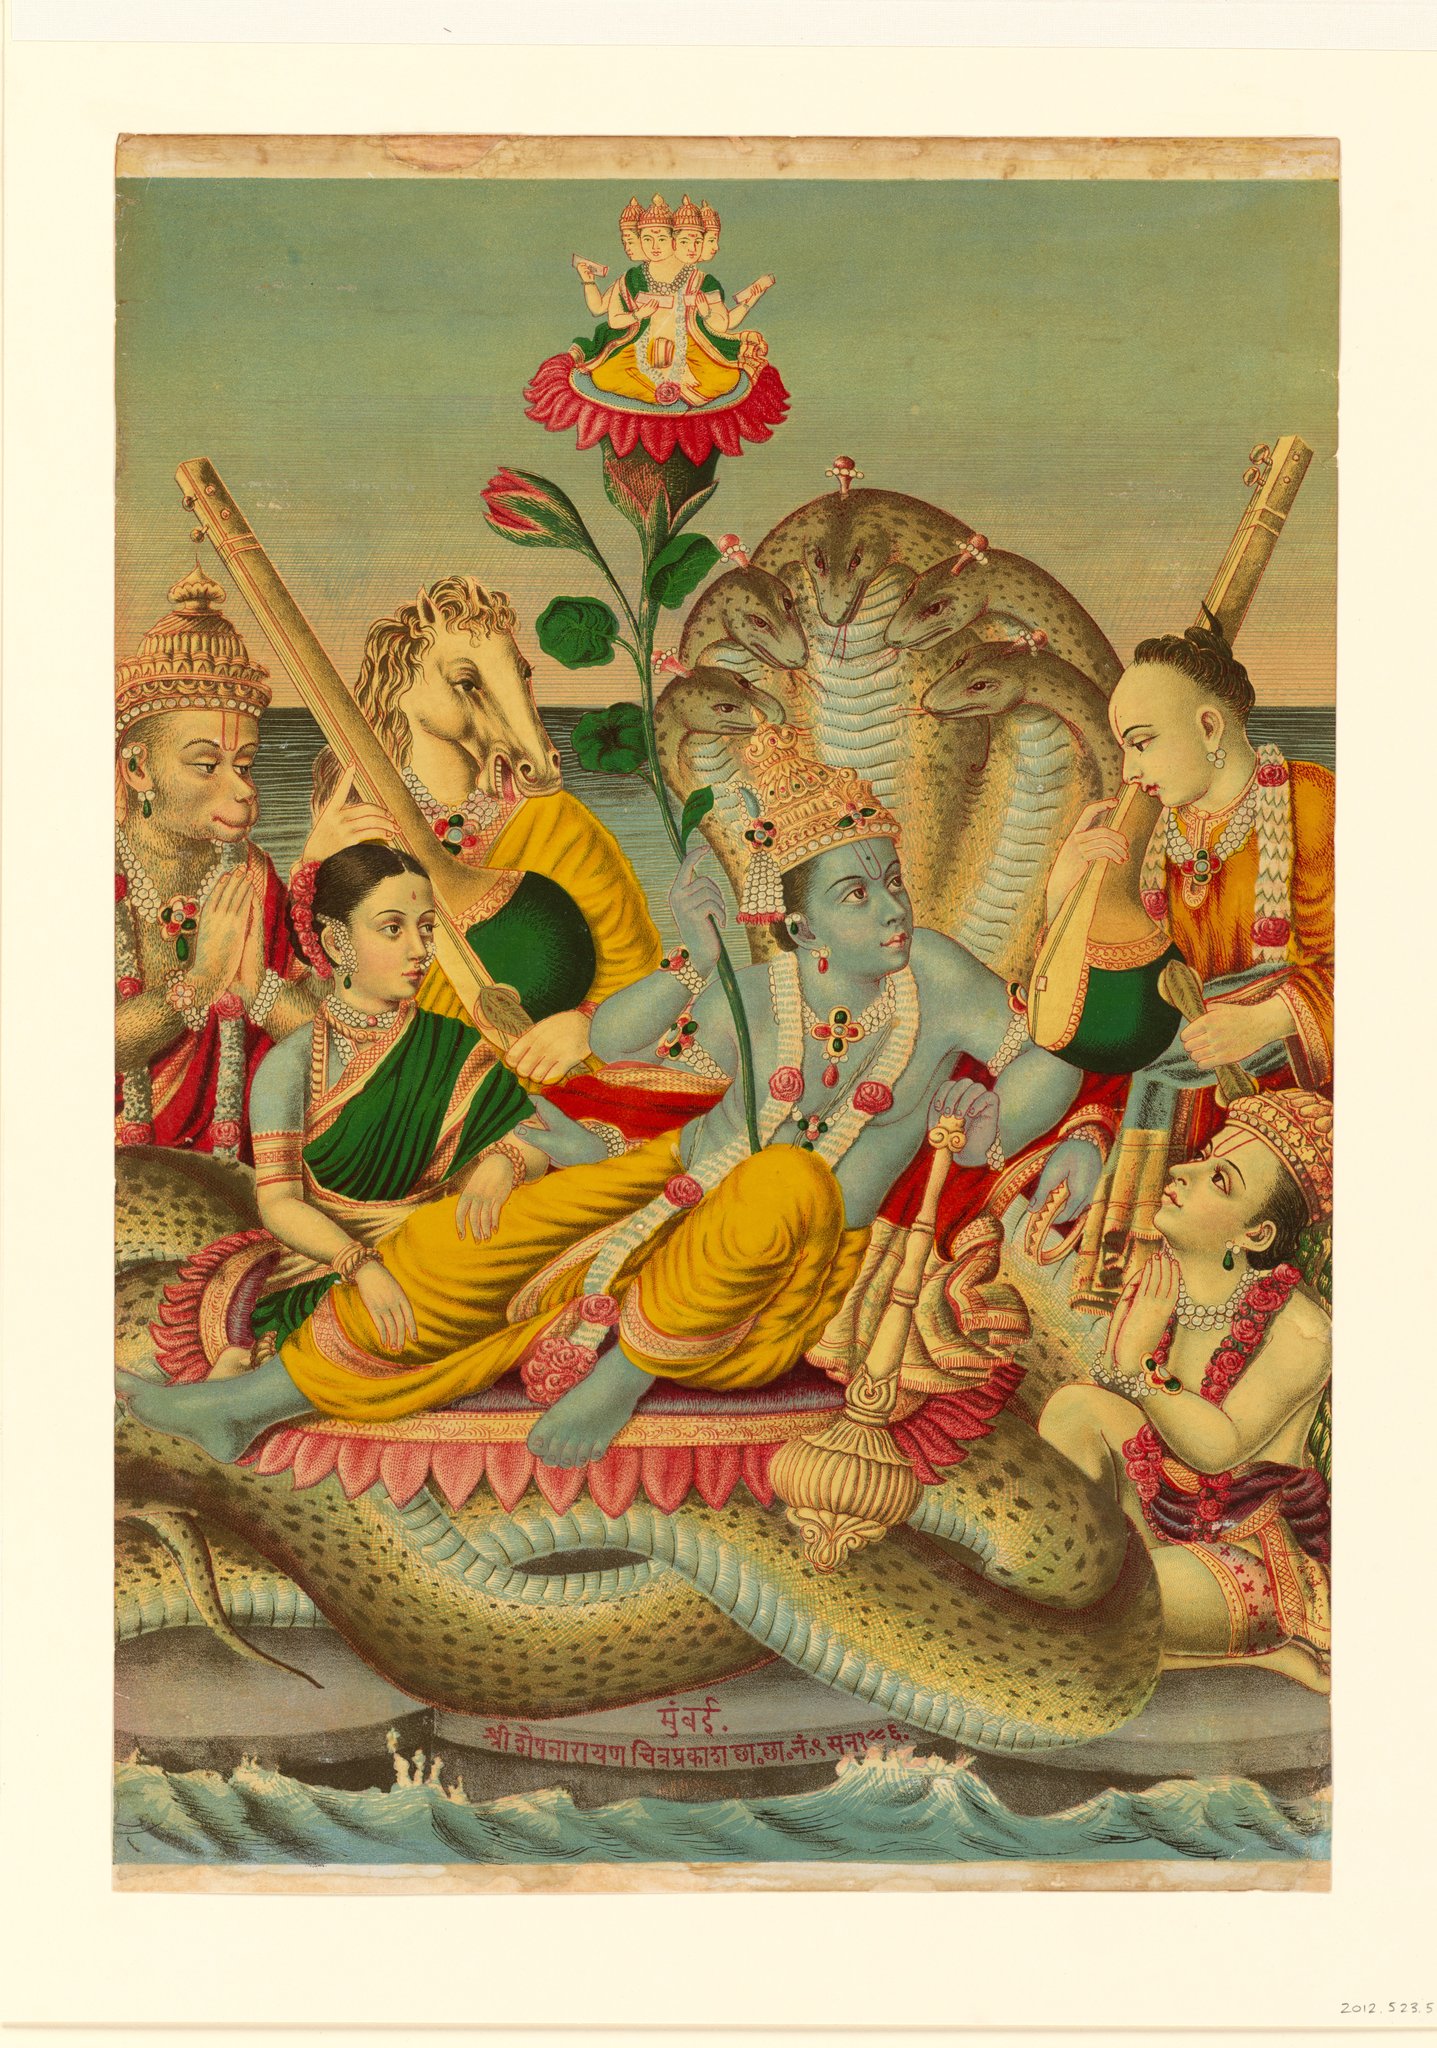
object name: lithograph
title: Shri Sheshanarayana, Vishnu Narayana on Shesha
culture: indian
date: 1886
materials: chromolithograph, paper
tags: vishnu